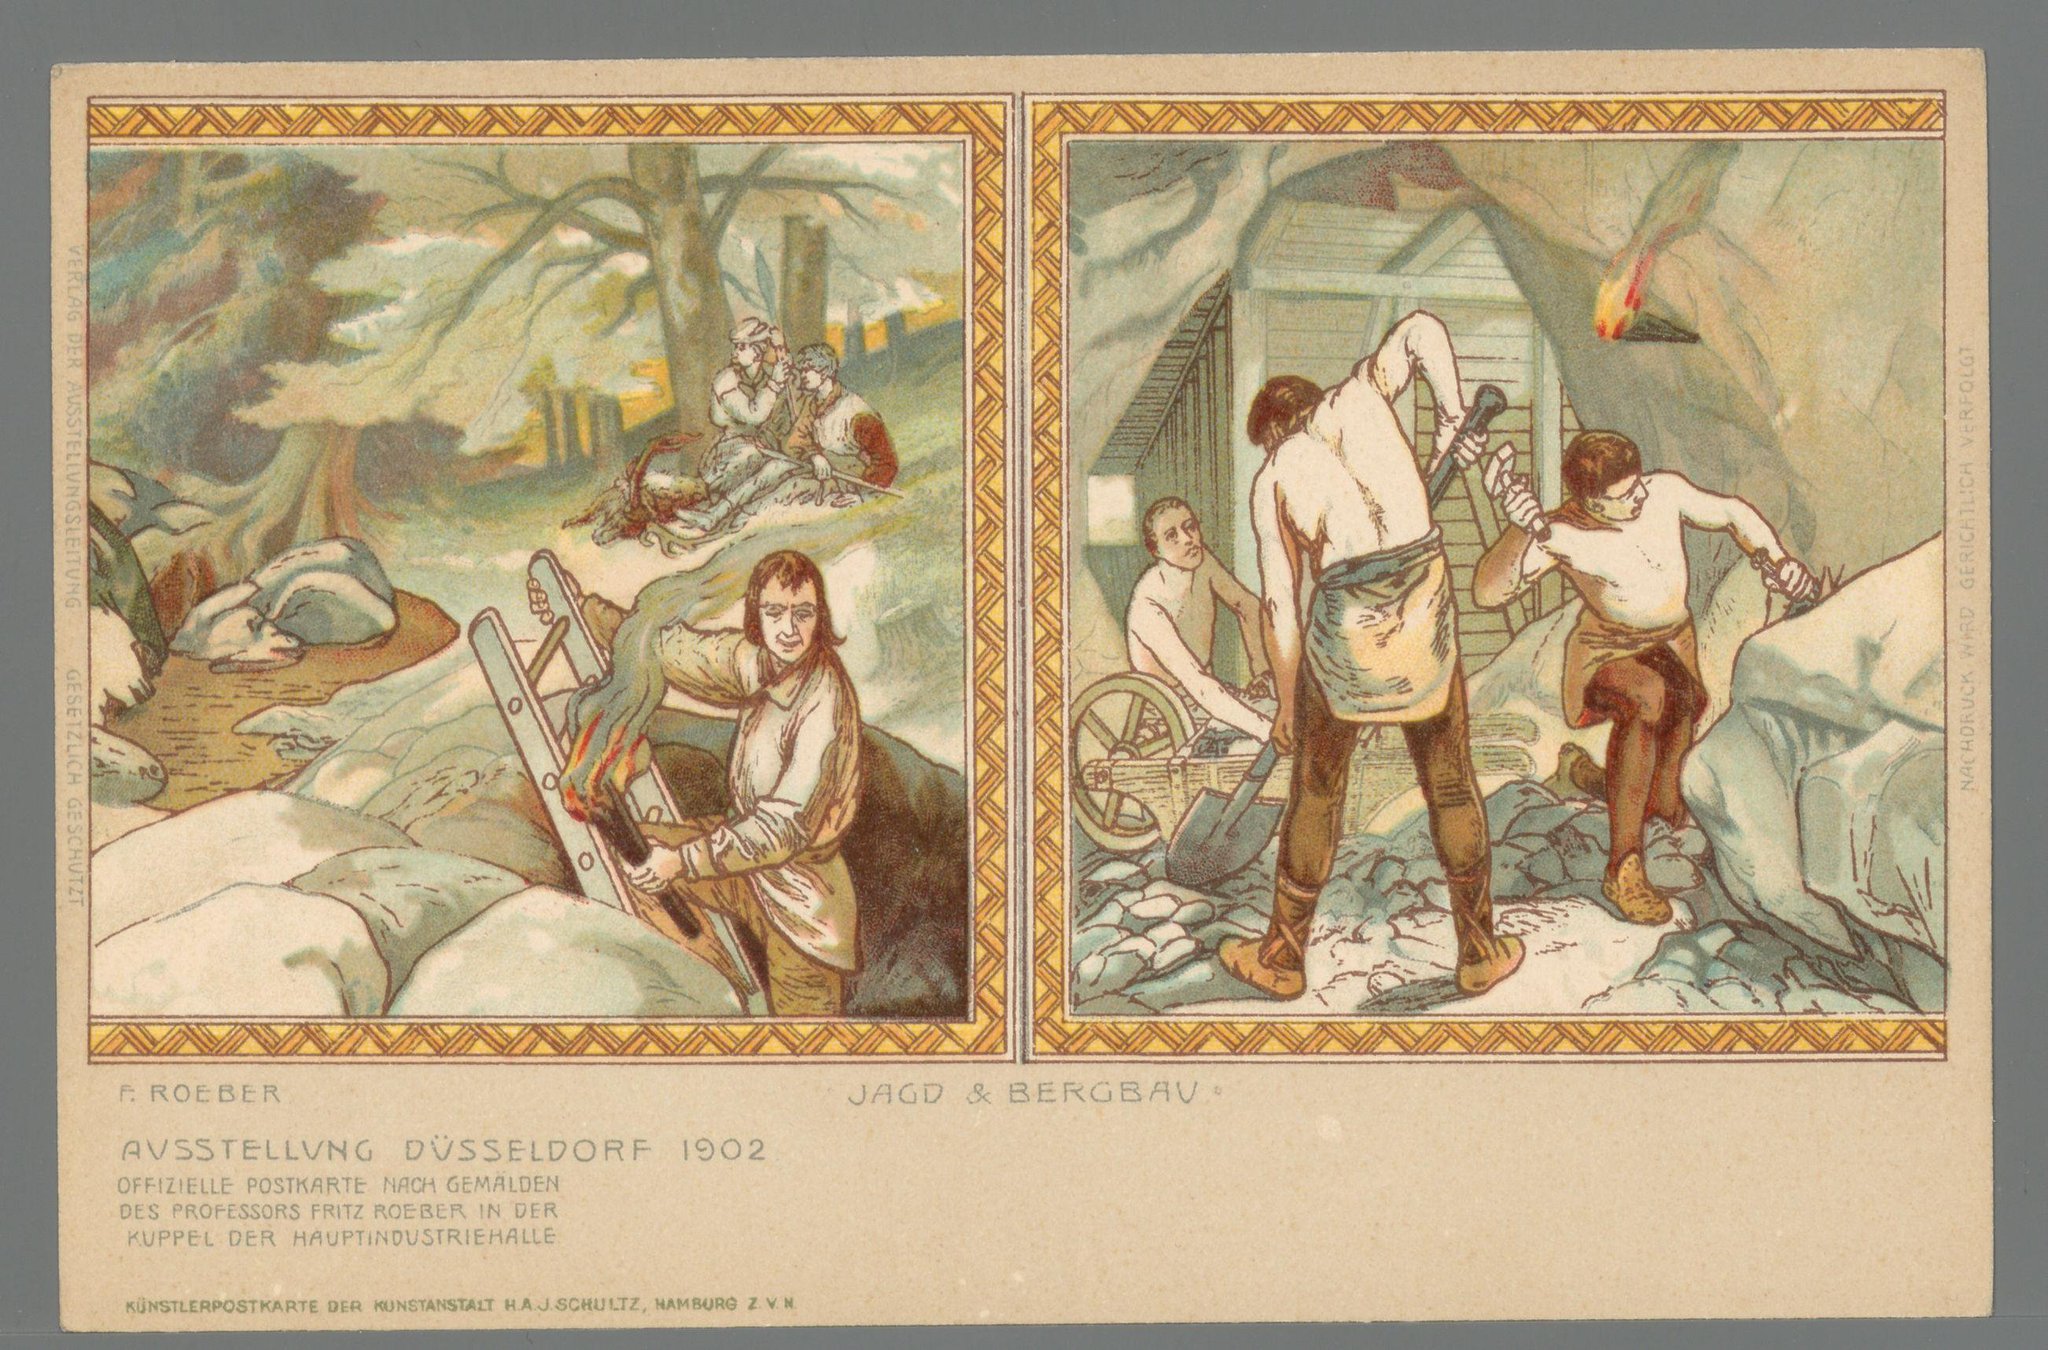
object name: ansichtkaart, prentbriefkaart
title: Jagd & Bergbau. Ausstellung Düsseldorf 1902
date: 1902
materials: cardboard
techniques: lithograph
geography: hamburg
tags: mining, hunters hunting (n.b.: in 1988-1990 this notation denoted the concept of 43c11421 'hunters resting during the hunt'), temporary exhibition, 'salon'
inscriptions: date